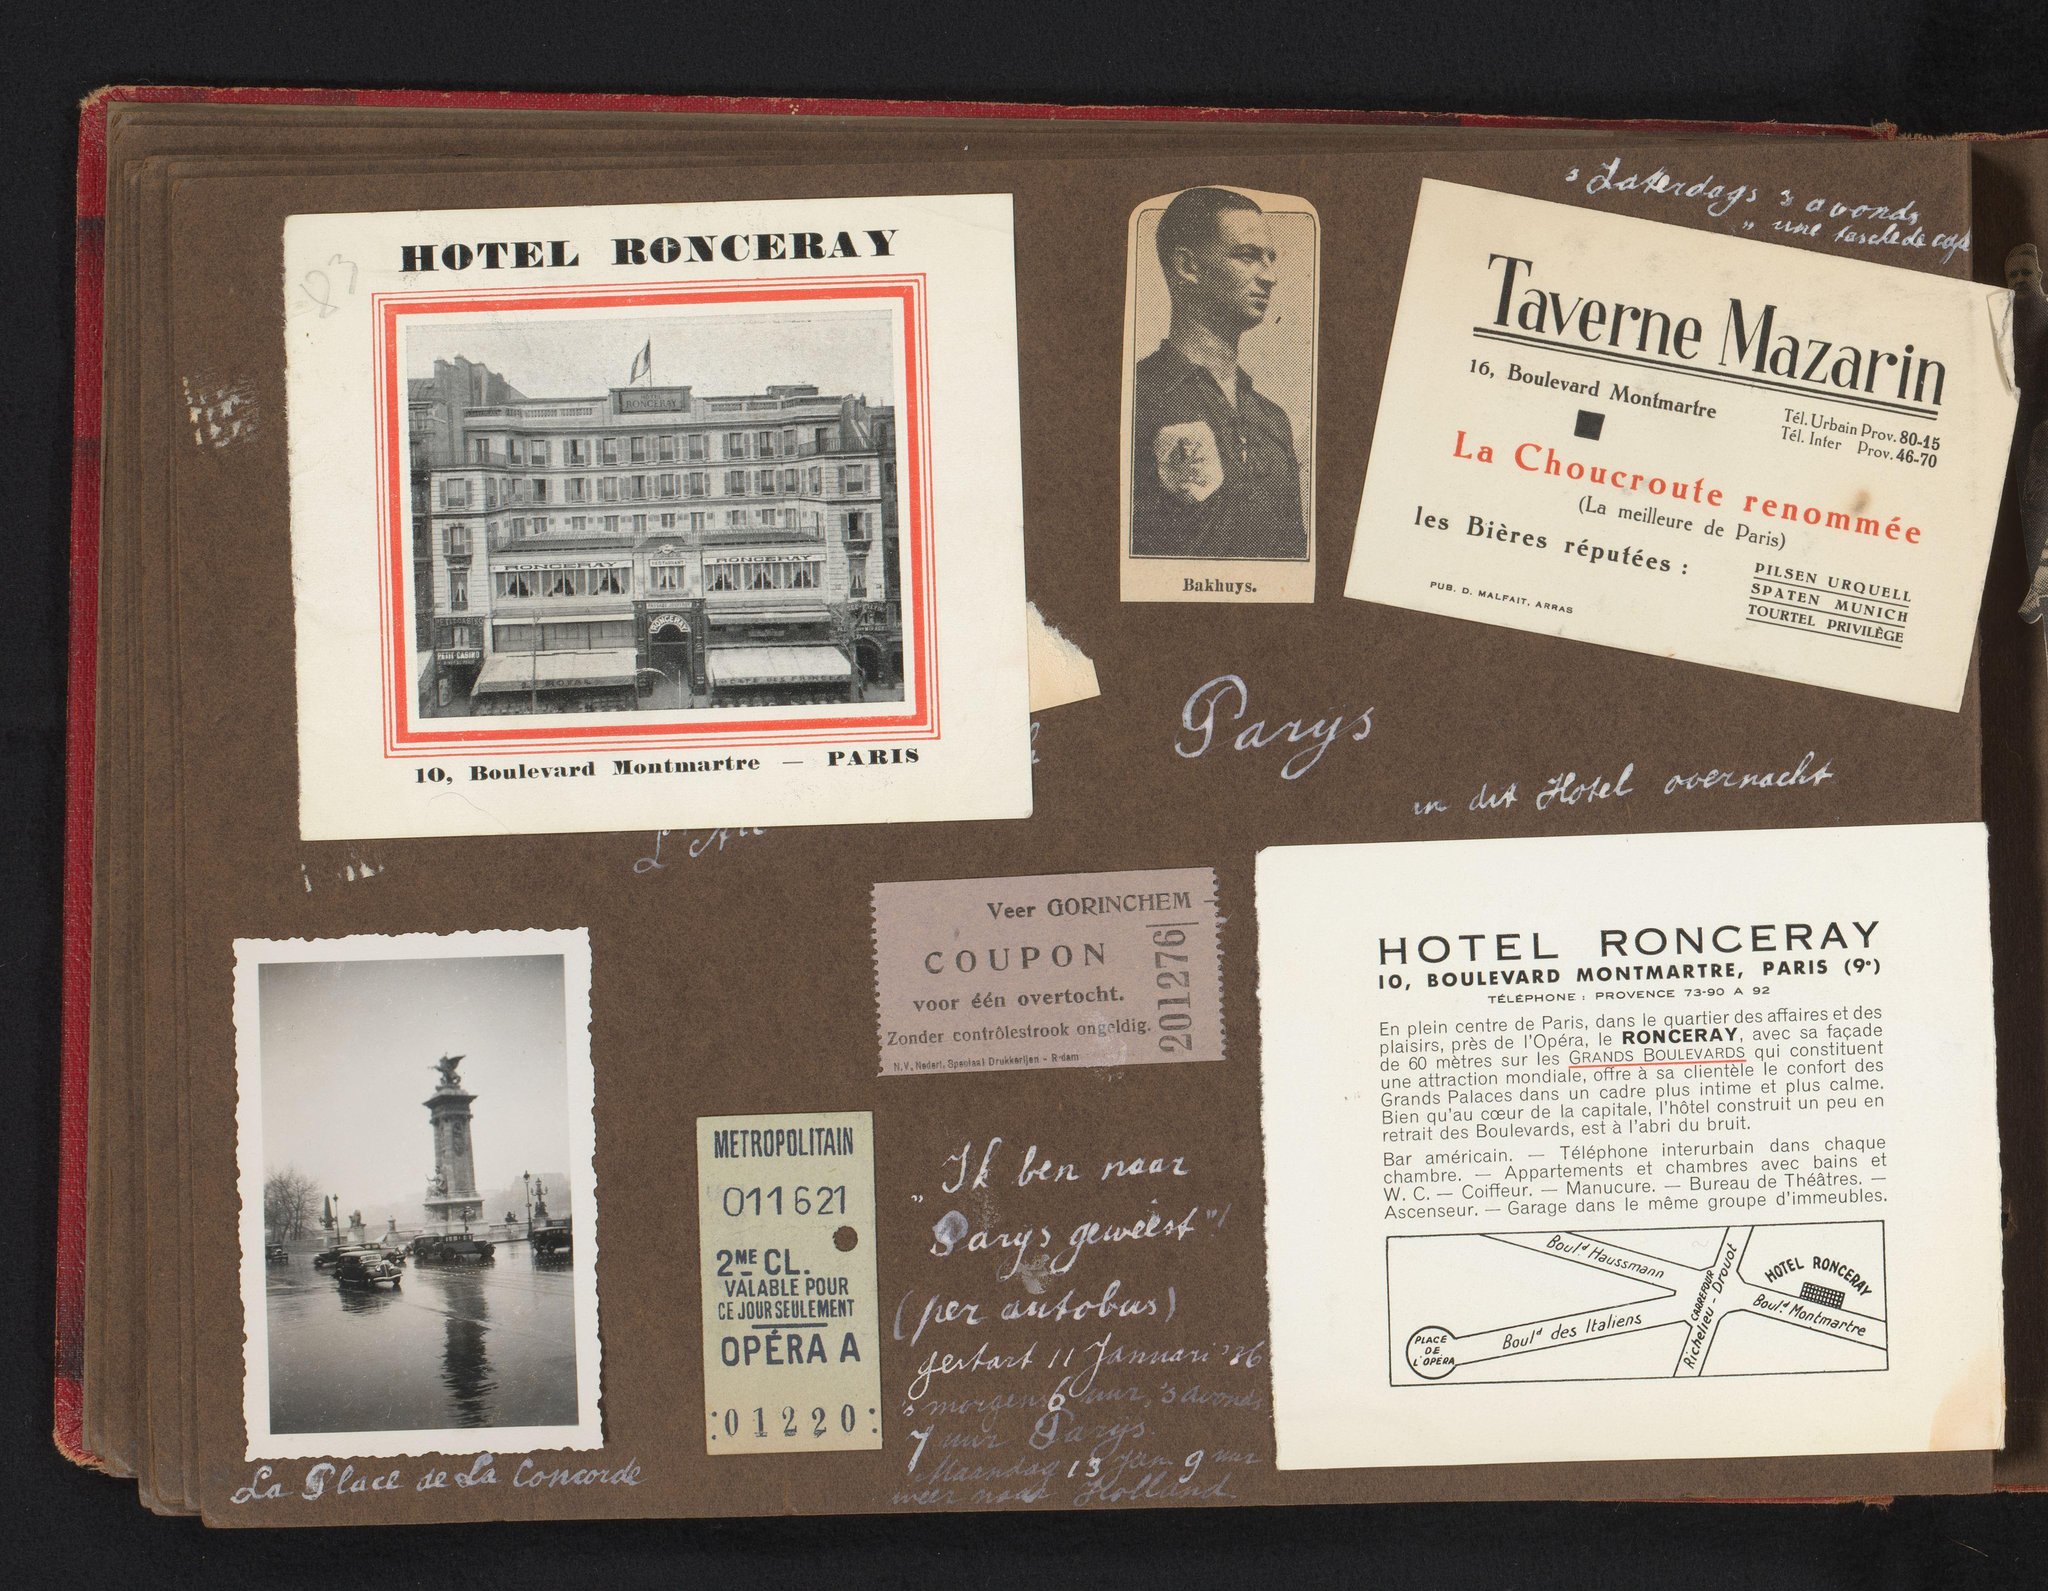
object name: admission ticket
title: Bezoek aan Parijs voor de voetbalwedstrijd Frankrijk-Nederland, 1936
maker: Anonymous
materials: paper, photographic support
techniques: gelatin silver print, offset printed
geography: paris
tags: soccer, football (early names: soule, choule, cholle), outing, pleasure trip, hotel, hostelry, inn, paris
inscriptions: inscription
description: Albumblad met een foto, een metrokaartje, folders van het hotel (waarvan één los in een mapje) en restaurant en een krantenknipsel. Op 11 januari 1936 vertrekt de samensteller van het fotoalbum naar Parijs om daar op 12 januari een voetbalwedstrijd tussen Frankrijk en Nederland bij te wonen (Nederland wint met 6-1). Onderdeel van het reisalbum van de familie Van den Broek 1935-1937.